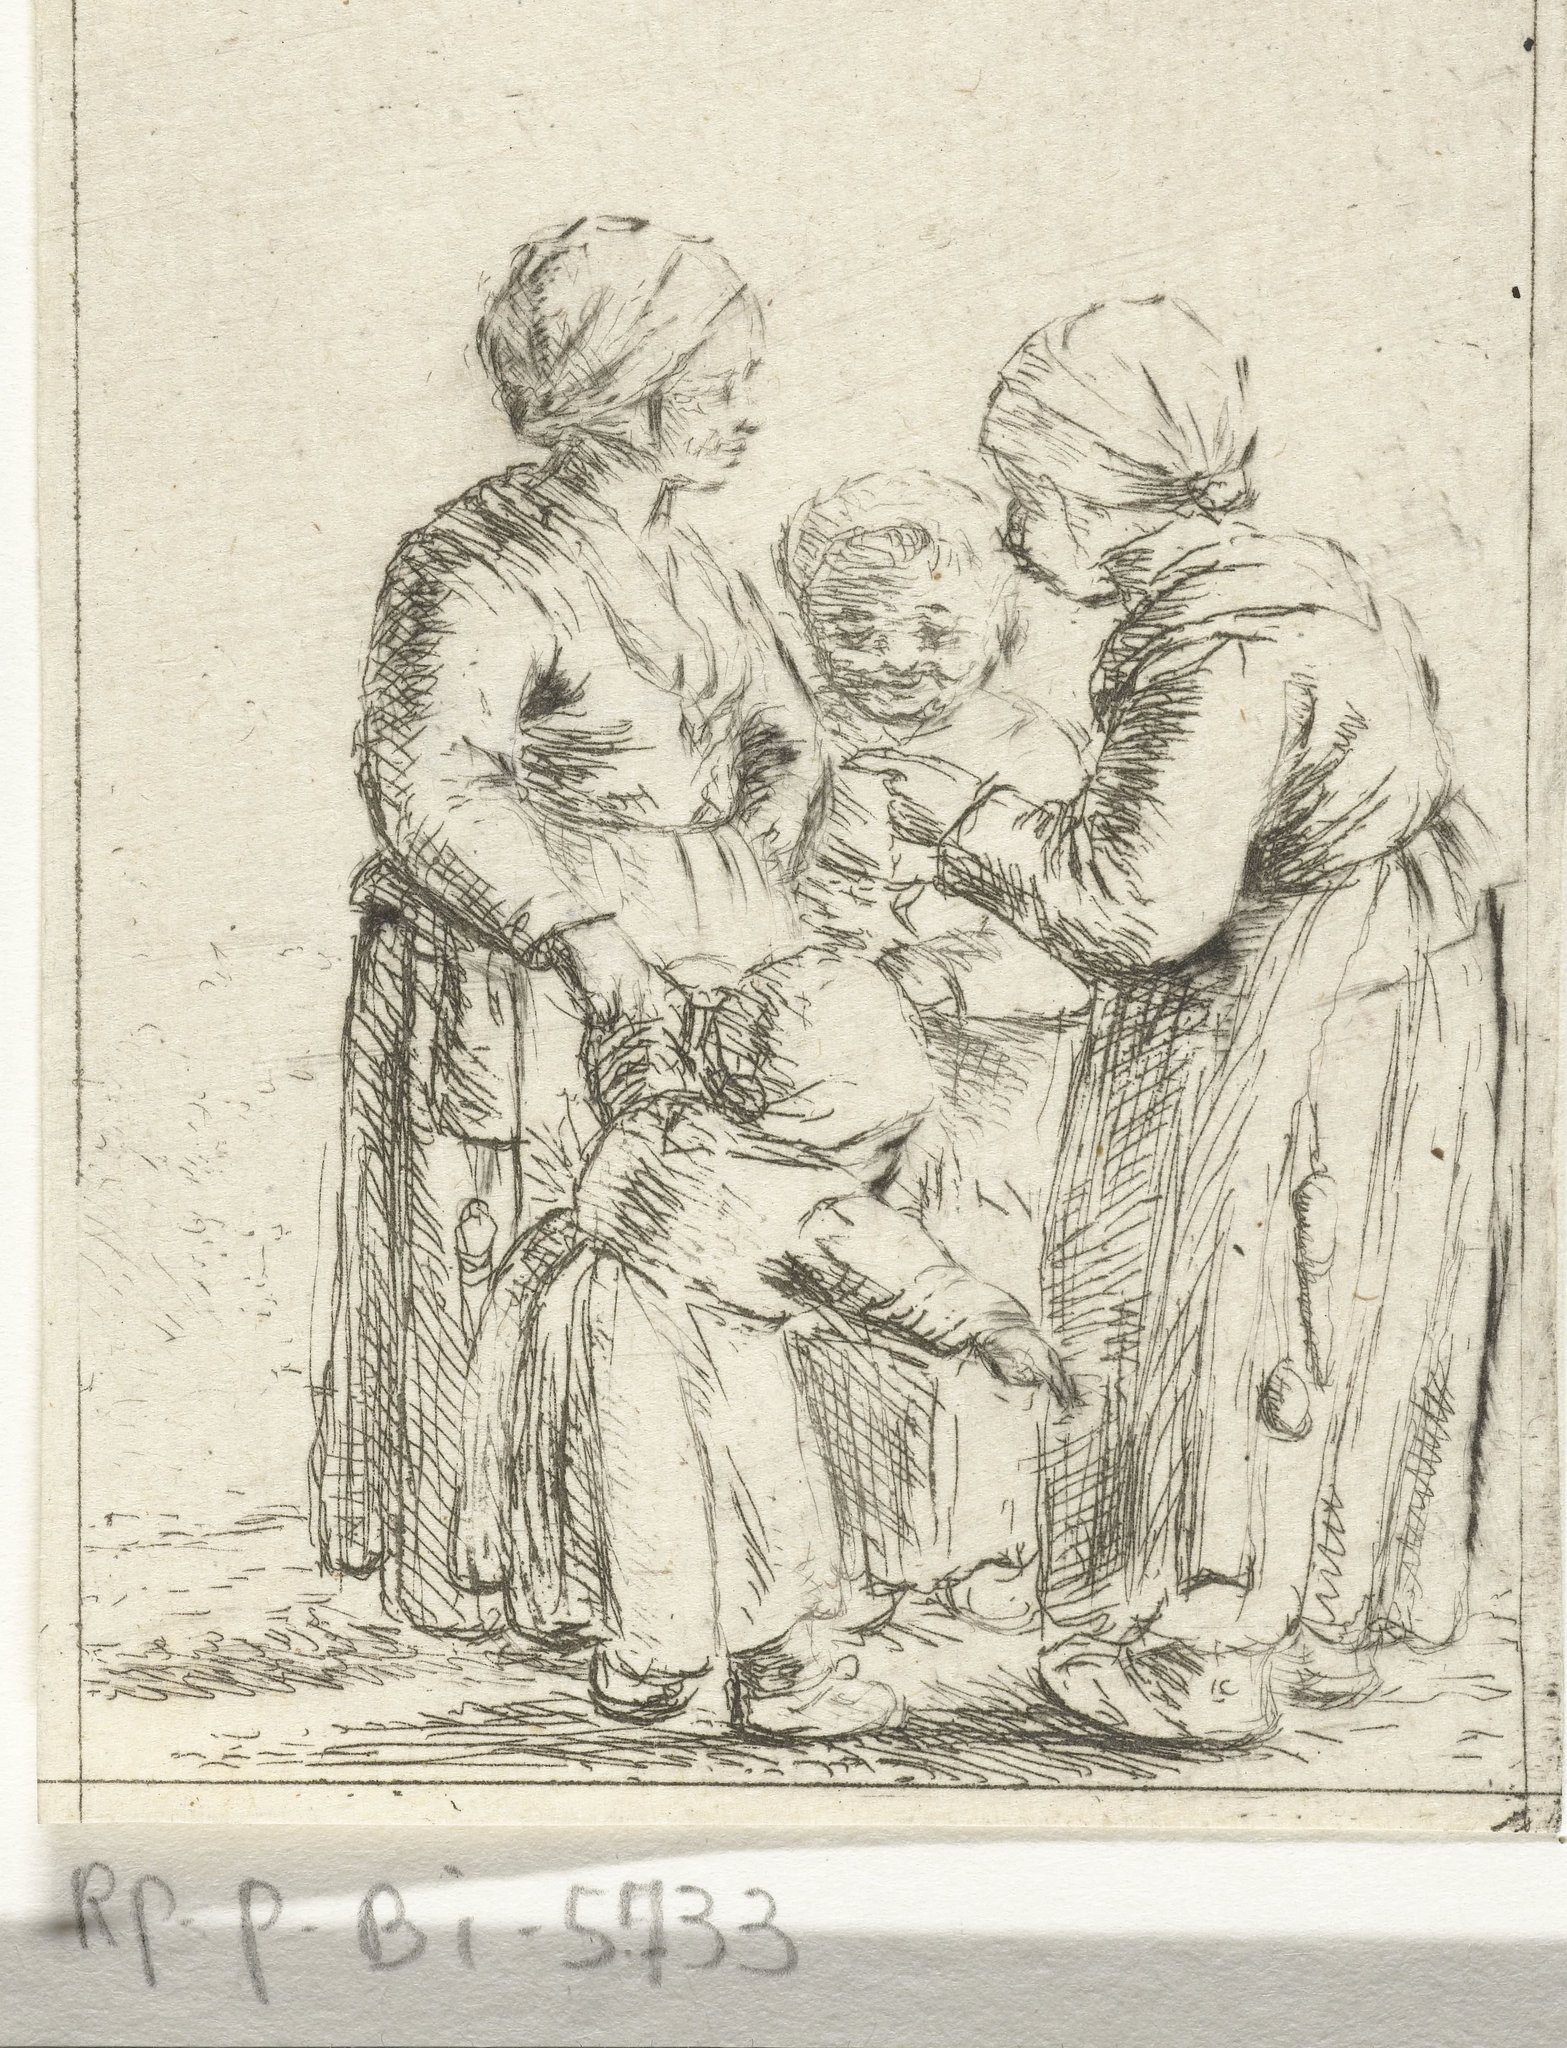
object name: print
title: Drie vrouwen in gesprek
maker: christina chalon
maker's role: draughtsman, print maker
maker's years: 1748-1808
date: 1758-1808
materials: paper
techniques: etching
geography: leiden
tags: human races; peoples; nationalities (+ women), mother and child(ren), woman and child(ren) (family group) (with number of children)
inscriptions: collector's mark: Lugt 240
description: Drie vrouwen staan bij elkaar en zijn druk in gesprek. Een van de vrouwen heeft een kind aan de hand.